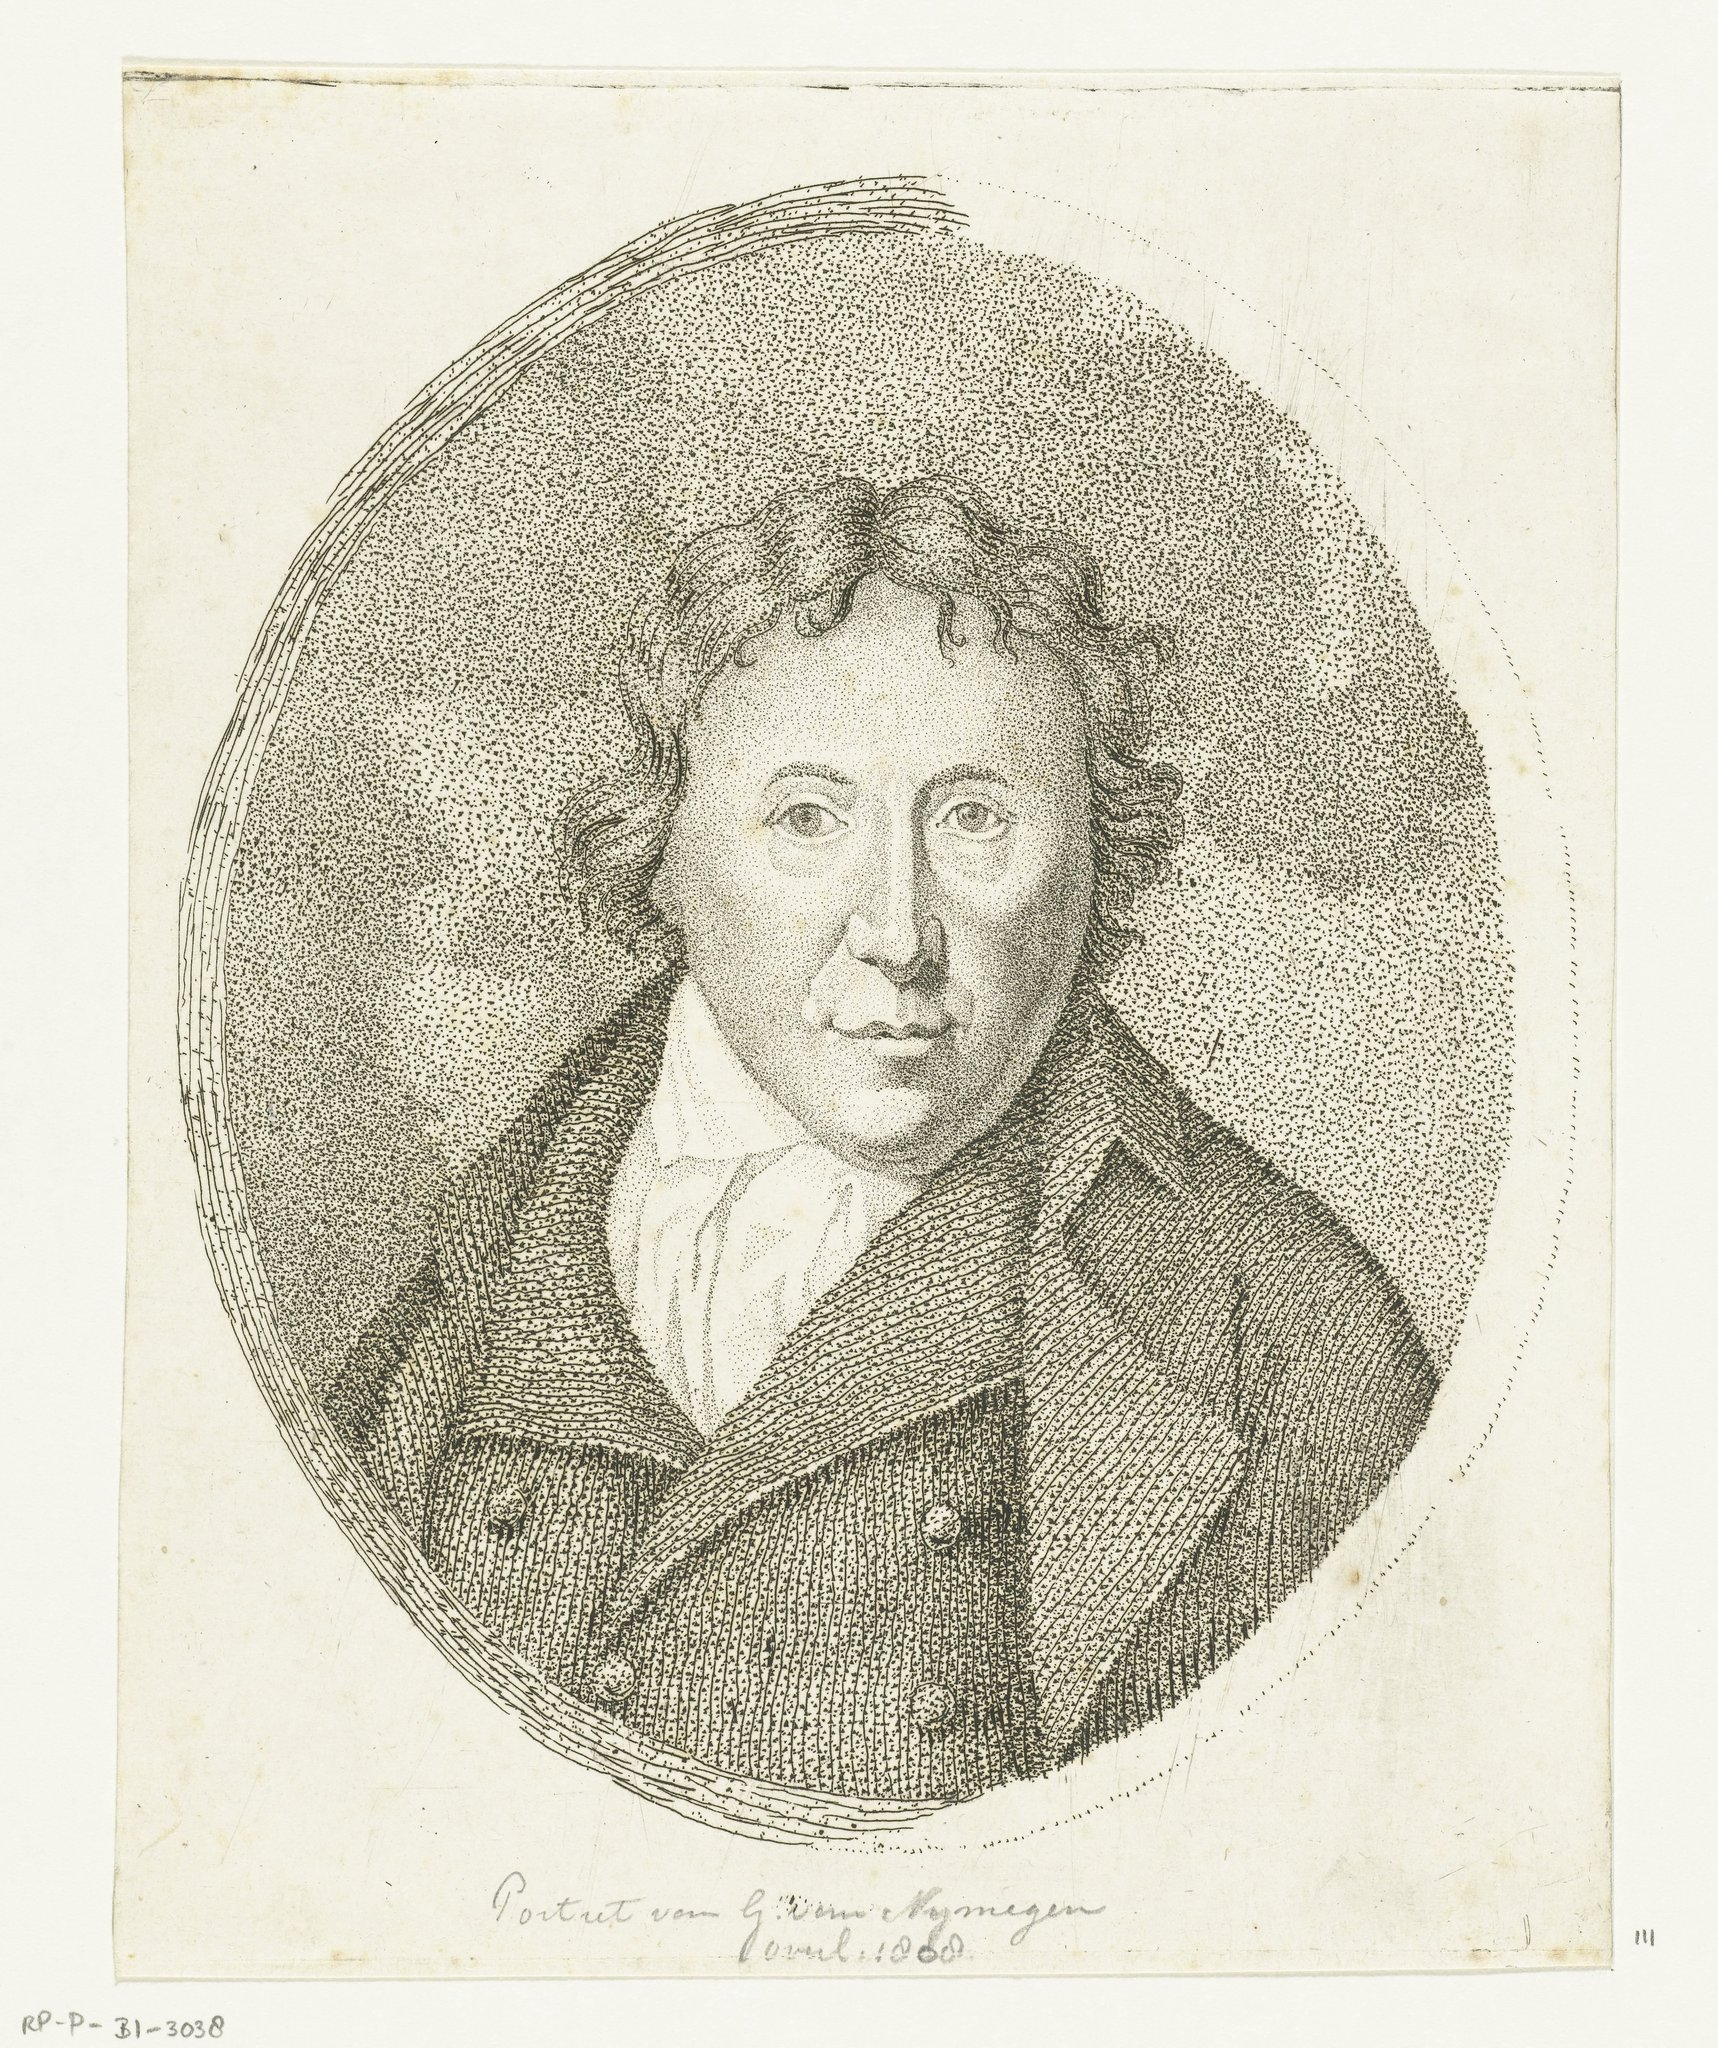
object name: print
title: Portret van Gerard van Nijmegen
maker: anthonie van den bos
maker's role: draughtsman, print maker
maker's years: 1763-1838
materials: paper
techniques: etching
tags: rotterdam, painter, print maker, draughtsman, gerard van nijmegen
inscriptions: collector's mark: Lugt 2228, inscription: ‘Portret van G. van Nymegen overl. 1808’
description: Borstbeeld van de Rotterdamse schilder Gerard van Nijmegen.